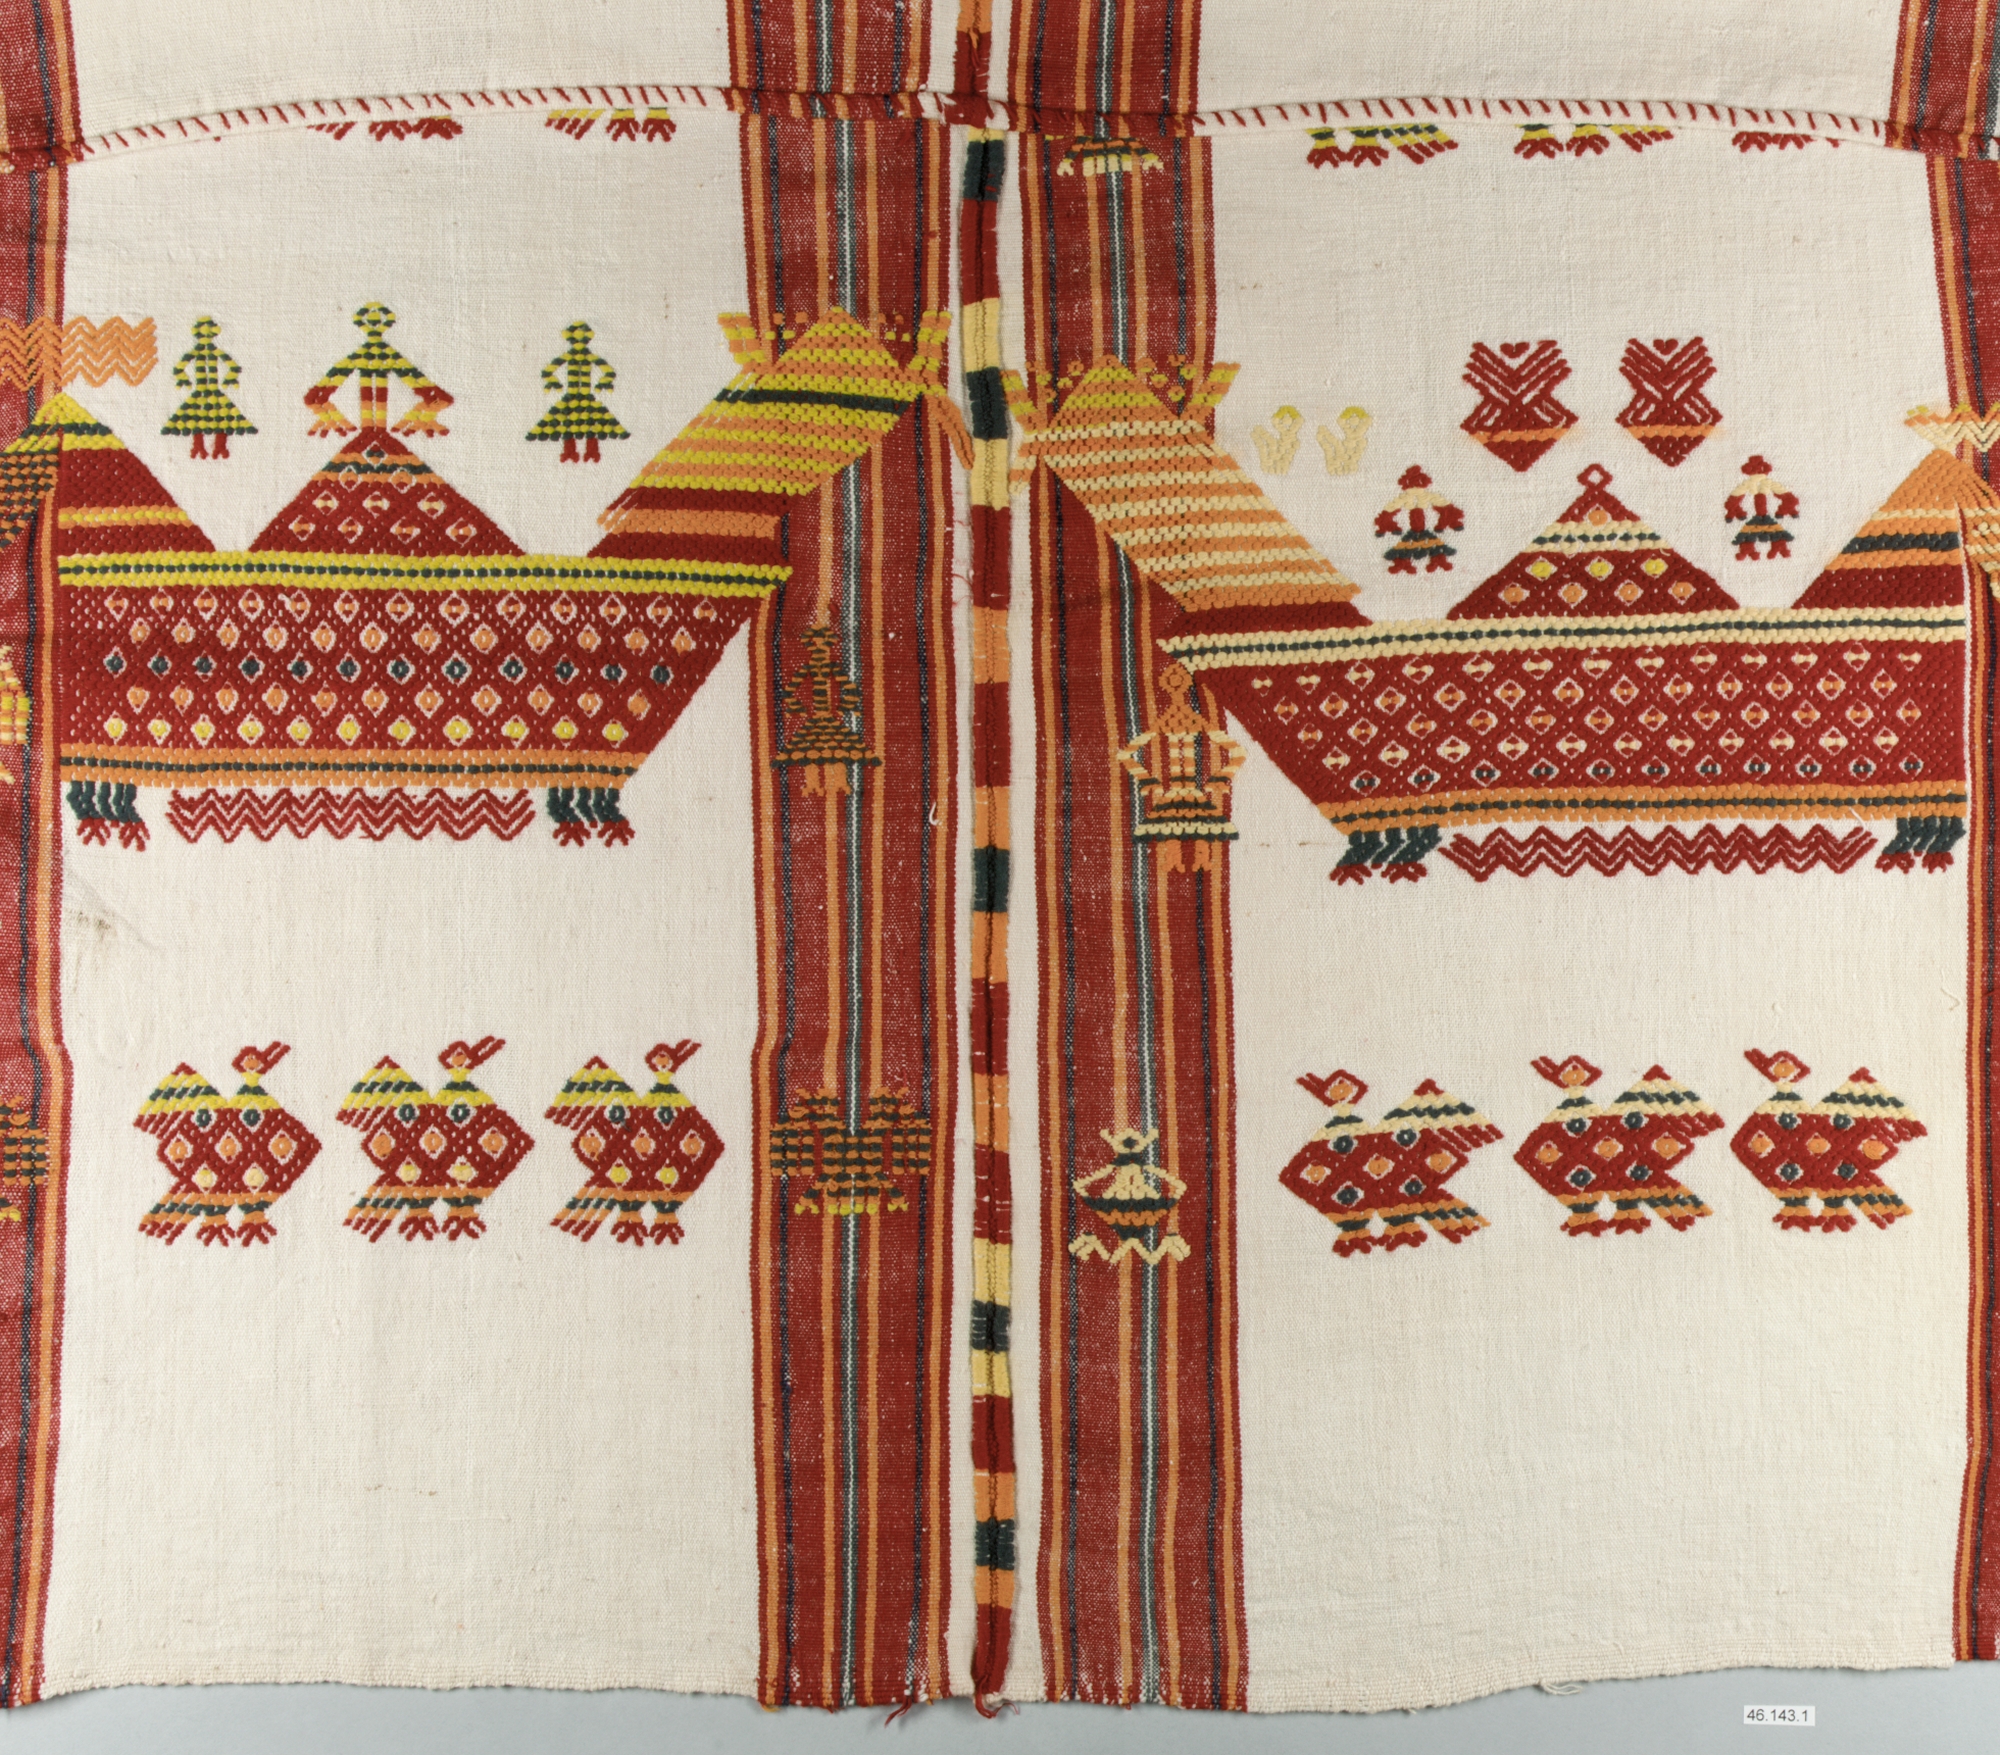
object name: cloth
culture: guatemalan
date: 1801-1900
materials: cotton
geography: guatemala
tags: birds